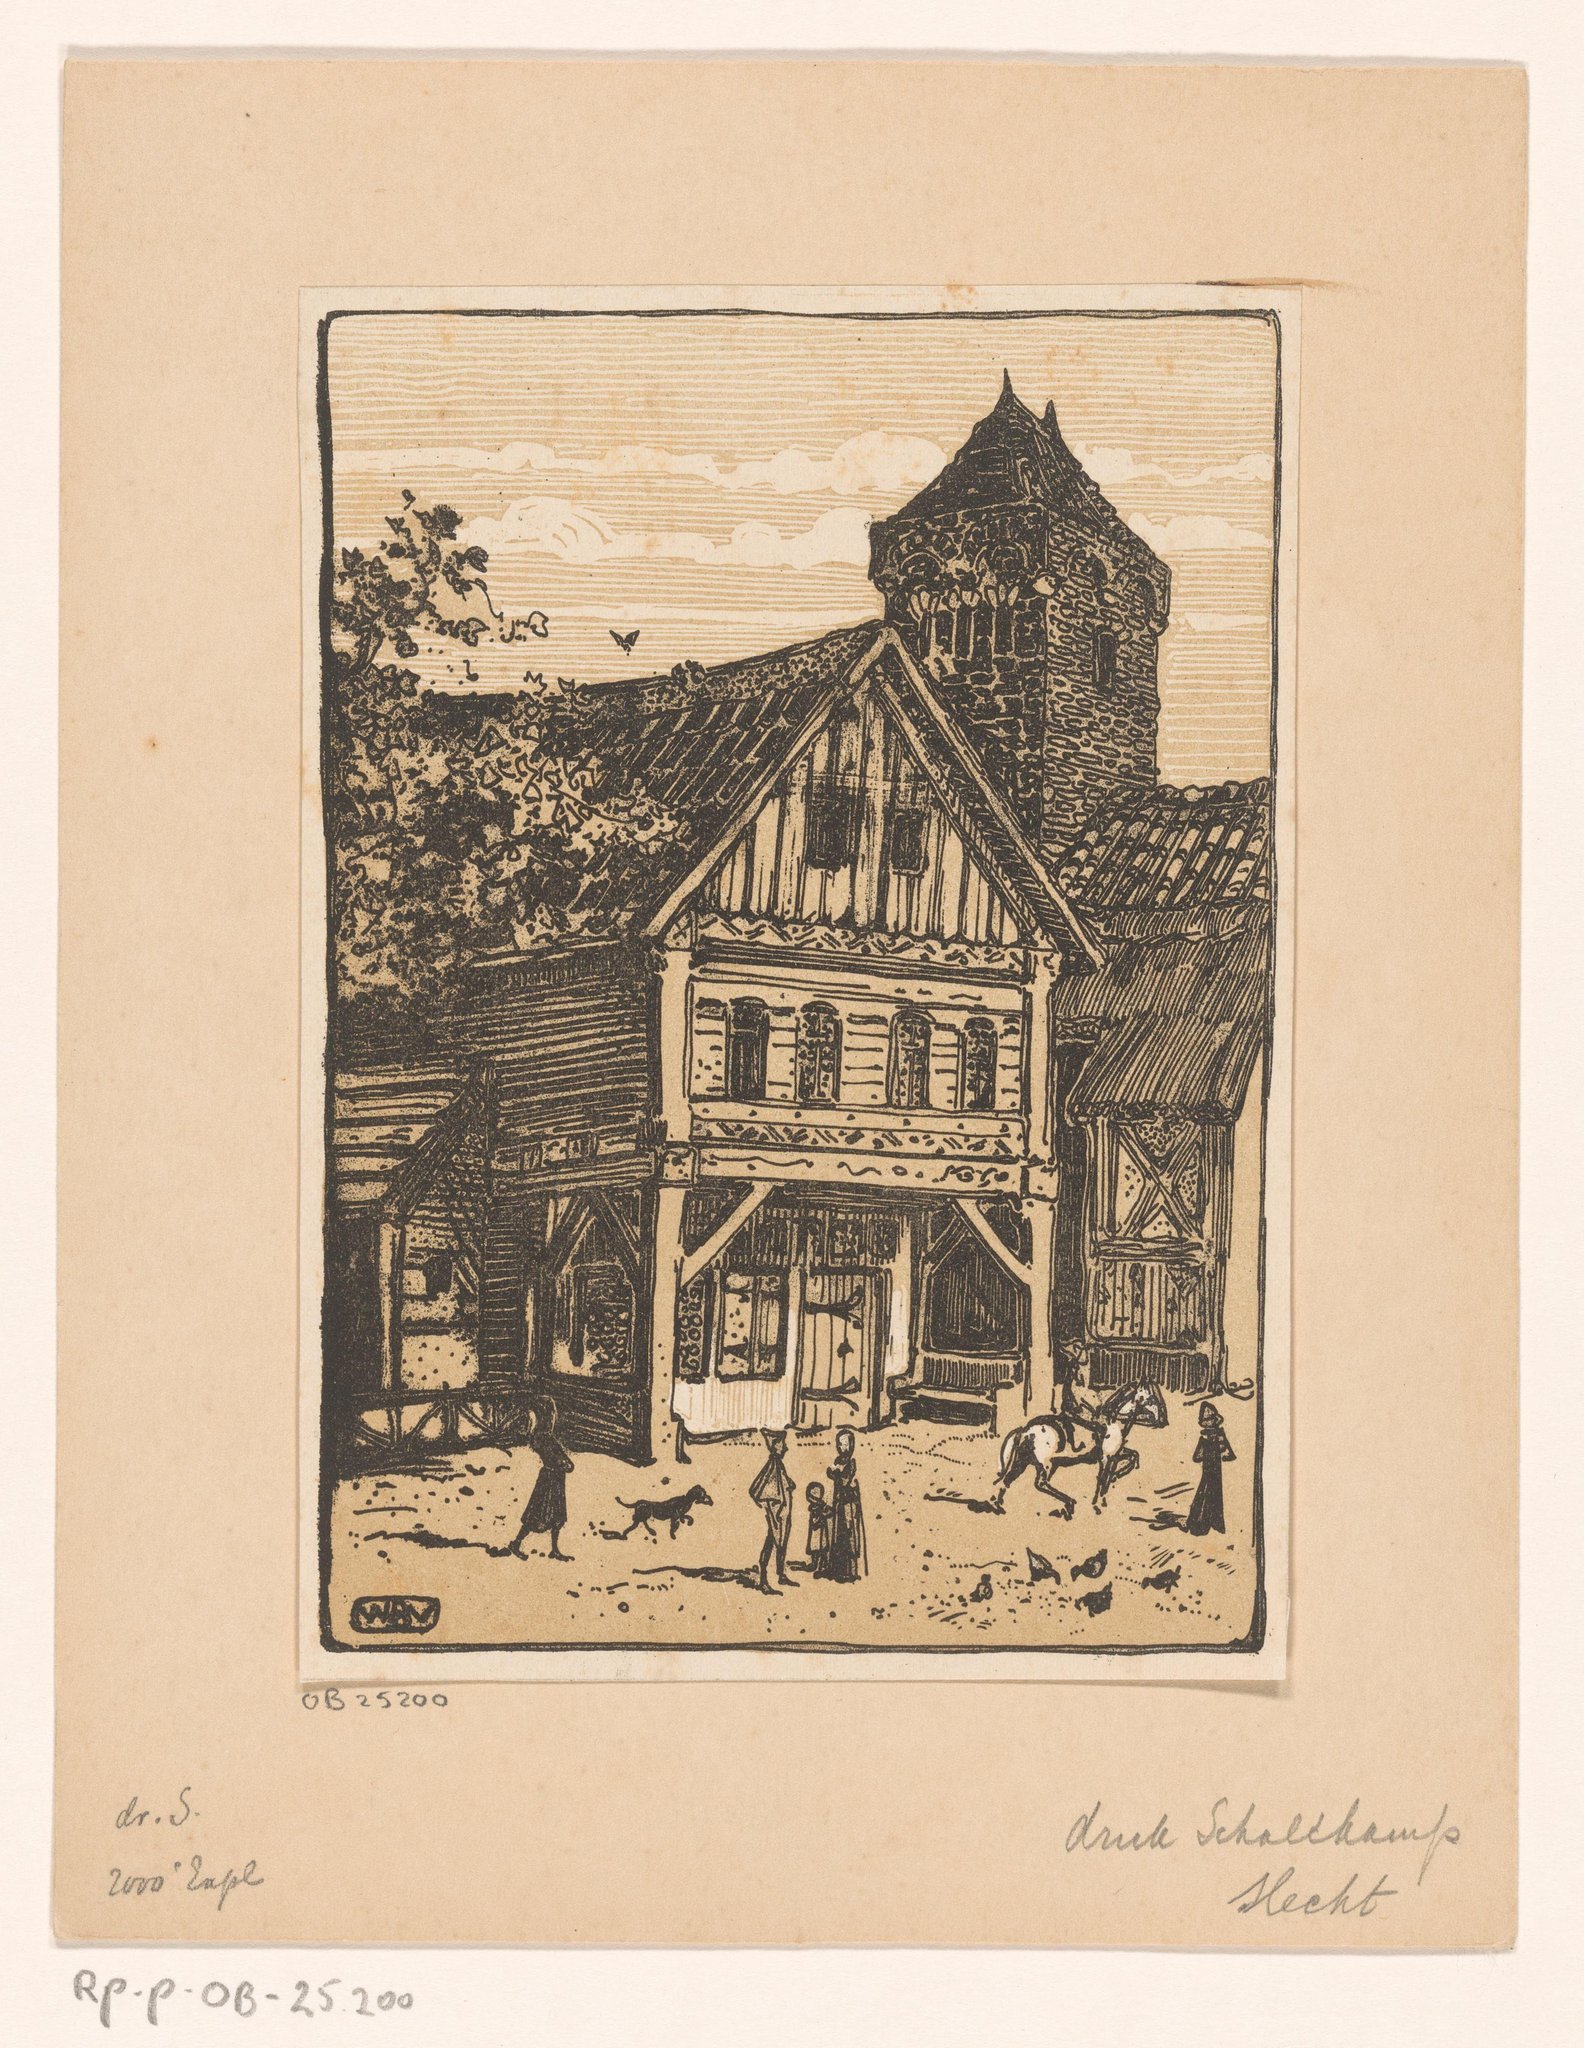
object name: print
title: Houten huis en stenen toren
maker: bernard willem wierink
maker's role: draughtsman, print maker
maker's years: 1856-1939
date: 1866-1939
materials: paper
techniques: relief print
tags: urban housing, tower (of house or building)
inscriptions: collector's mark: Lugt 2228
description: Deze prent is vermoedelijk een plaatsnede, ook al wordt in de literatuur veelal gesproken over een houtsnede. Voor zover Wierink zijn prenten in hoogdruk zelf nader heeft omschreven, heeft hij altijd de term 'plaatsnede' gebruikt.